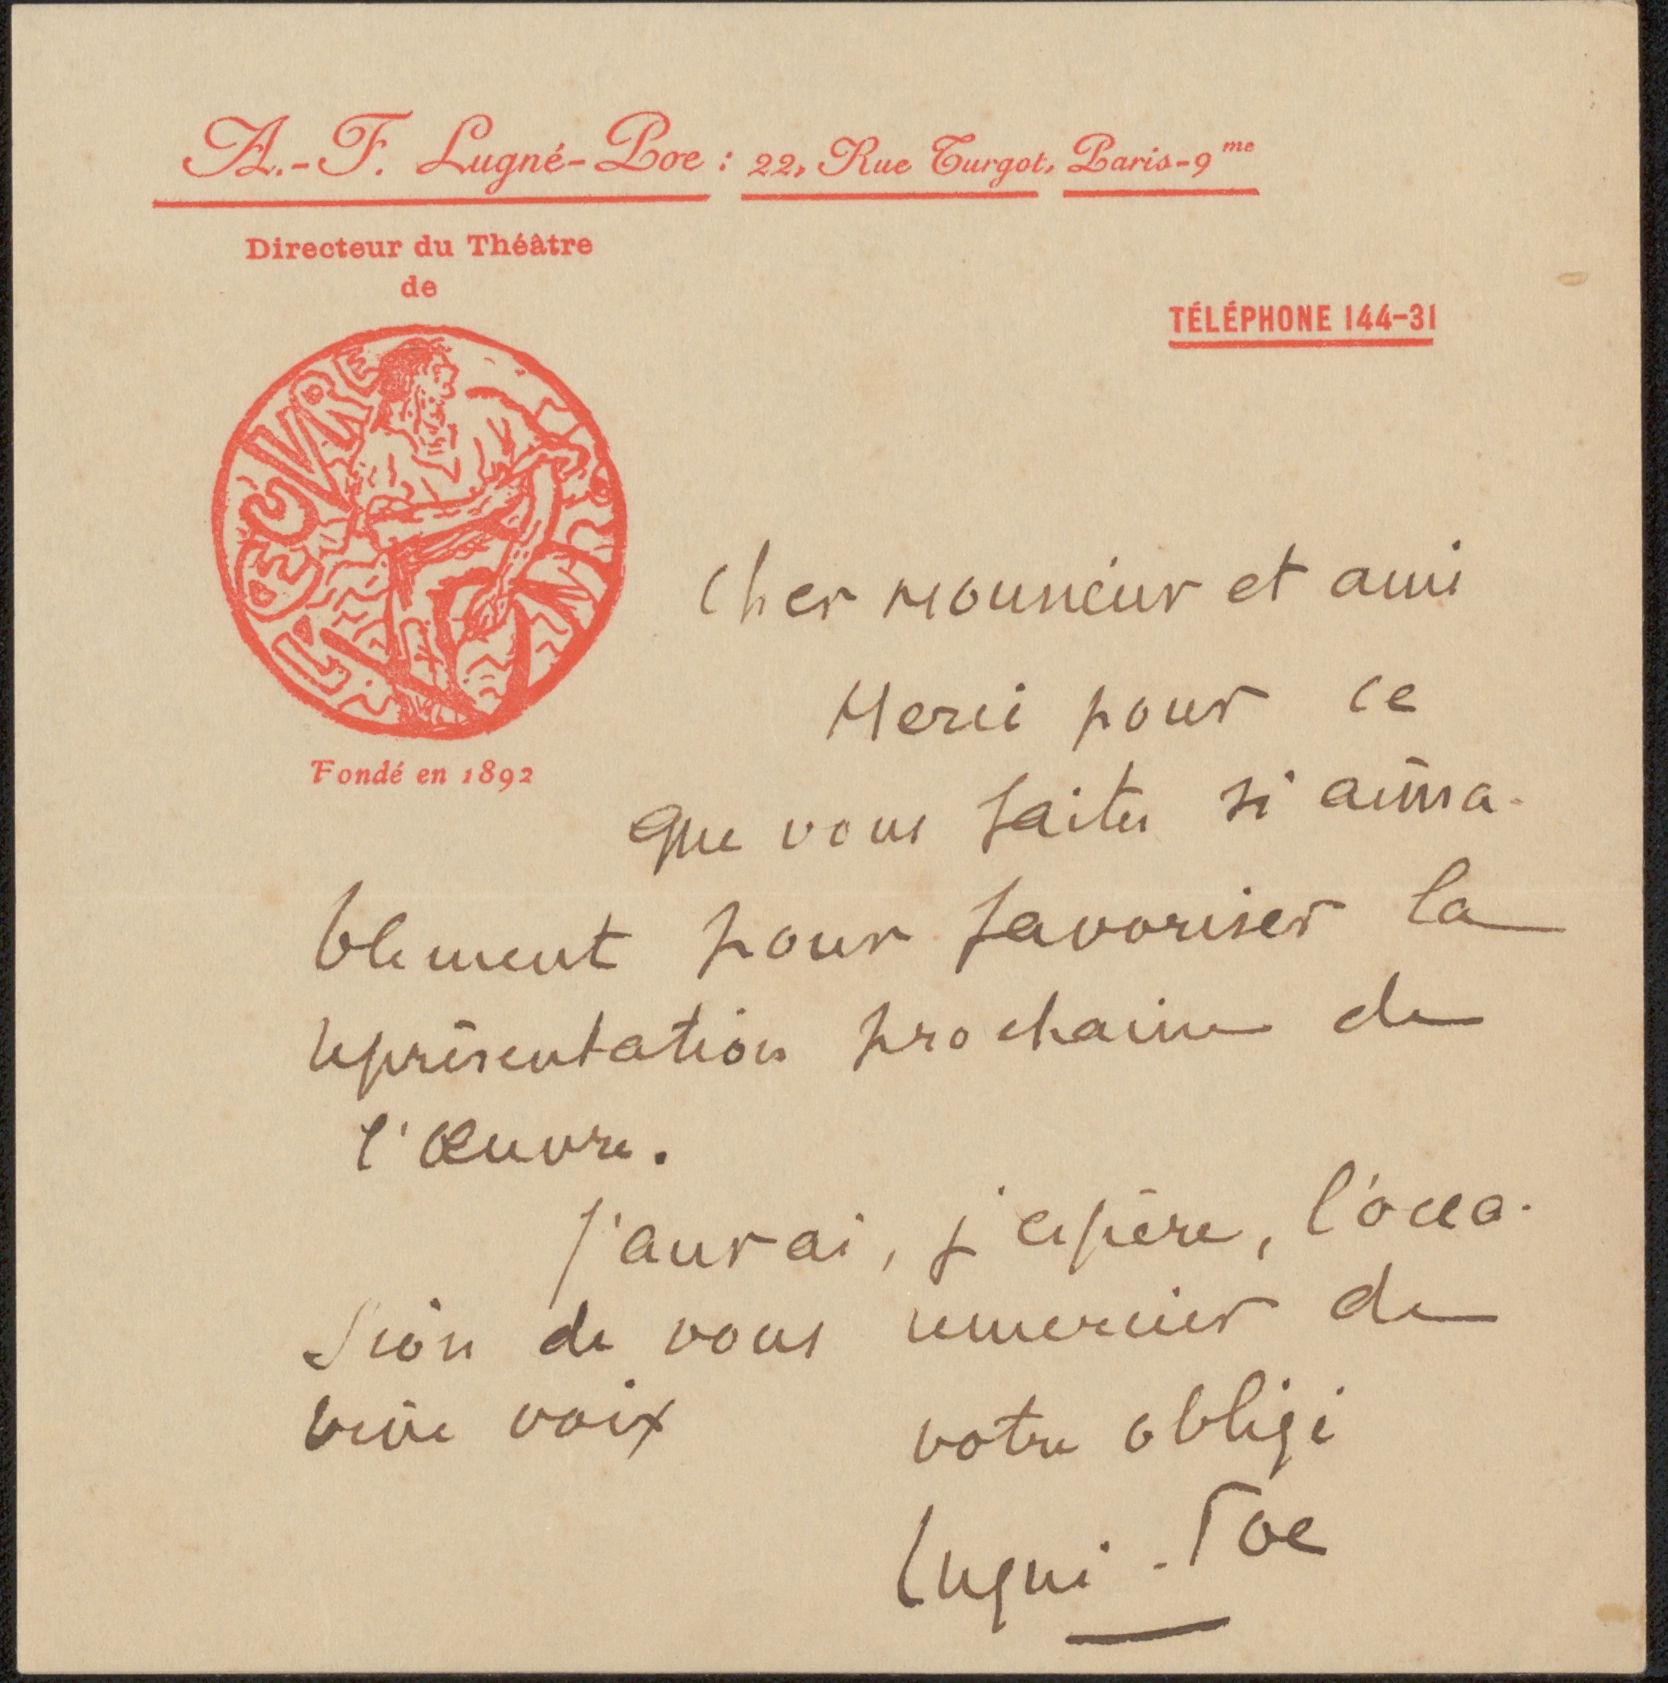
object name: letter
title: Brief aan Philip Zilcken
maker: lugné-poe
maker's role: acteur, theaterdirecteur, theatervormgever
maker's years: 1869-1940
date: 1879-1930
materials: ink, paper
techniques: pen, printing, writing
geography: paris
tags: the hague, painter, draughtsman, philip zilcken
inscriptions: collector's mark: ‘RPK’